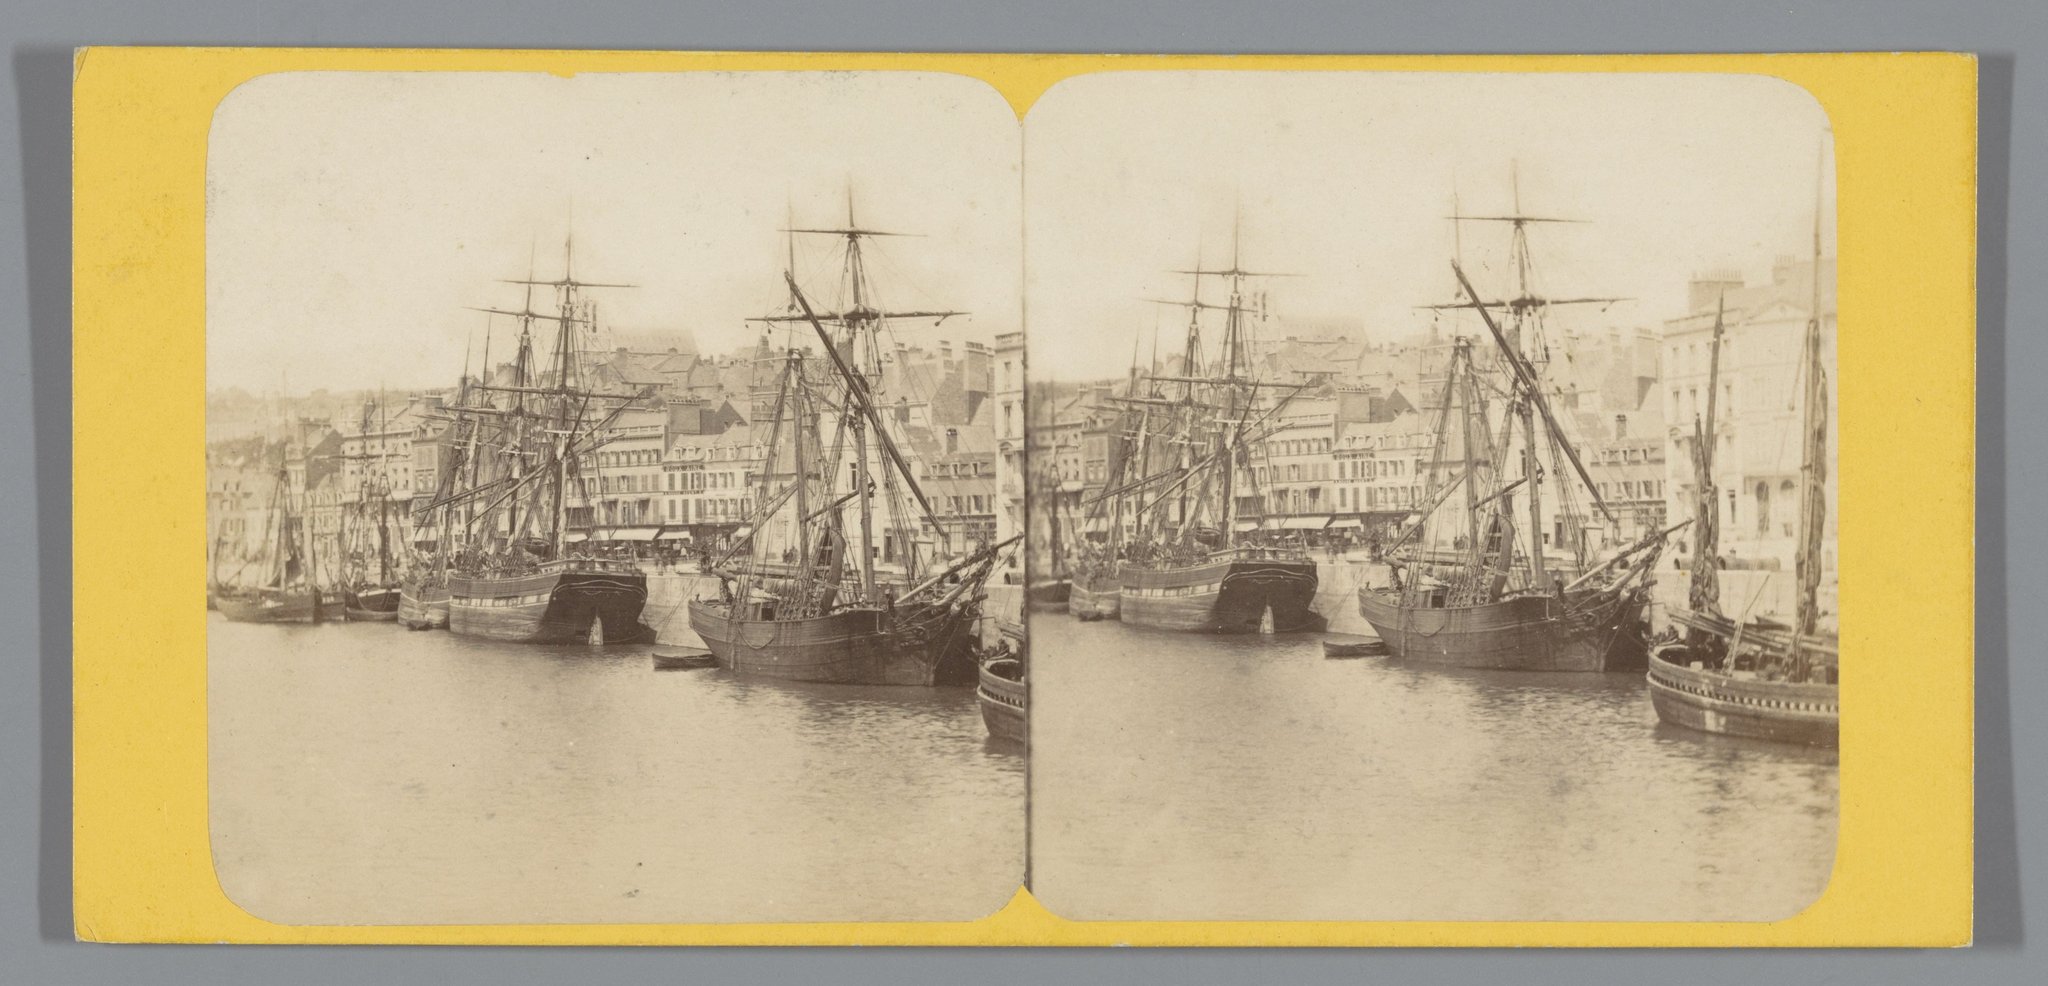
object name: stereograph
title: La france-Maritime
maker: Anonymous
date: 1860-1880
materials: cardboard, photographic support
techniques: albumen print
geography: boulogne-sur-mer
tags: ships (in general), pier, quay, wharf